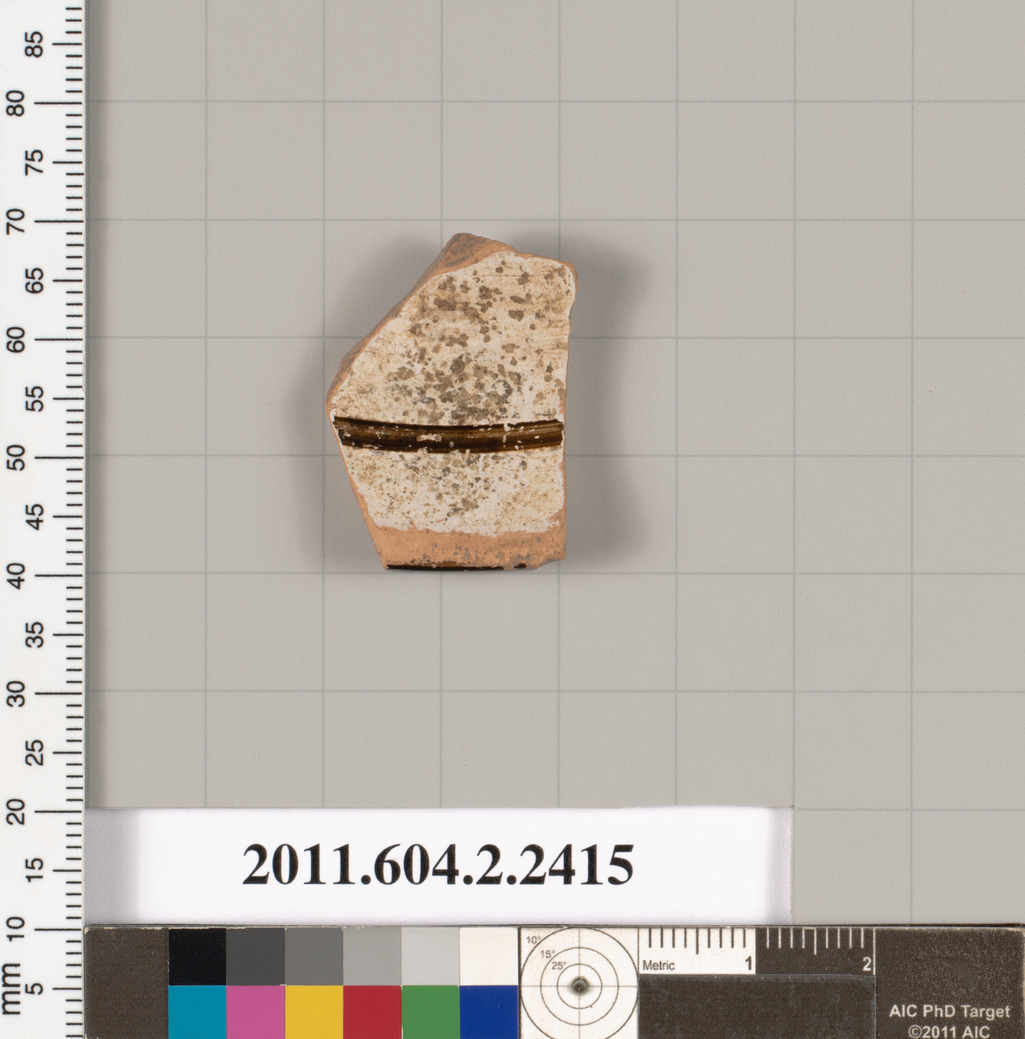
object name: kylix fragment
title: Terracotta rim fragment of a kantharos (drinking cup with high handles)?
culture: greek, attic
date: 480-460 BCE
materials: terracotta